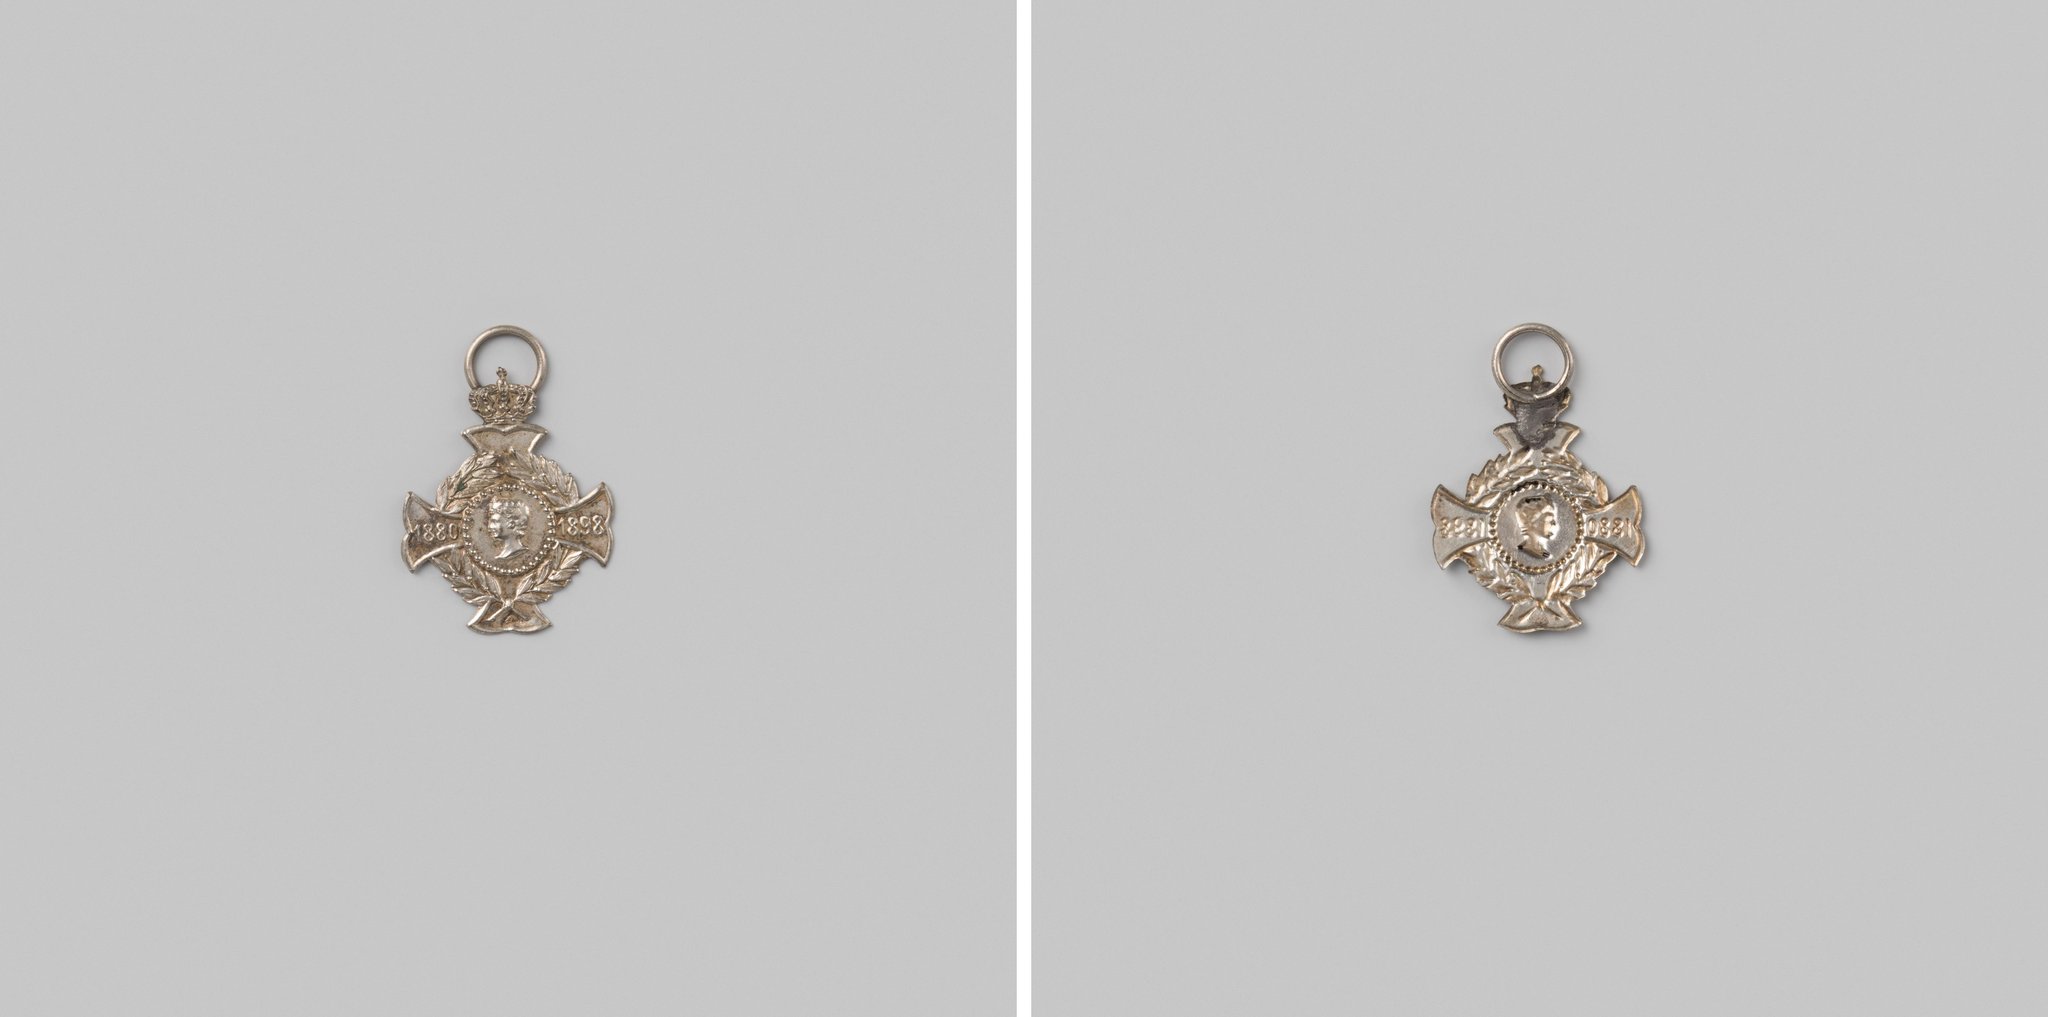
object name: insignia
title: Inhuldiging van Wilhelmina als koningin der Nederlanden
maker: a. rogmans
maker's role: silversmith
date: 1898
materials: silver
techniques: striking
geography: amsterdam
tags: the hague, print maker, wilhelmina of the netherlands, netherlands